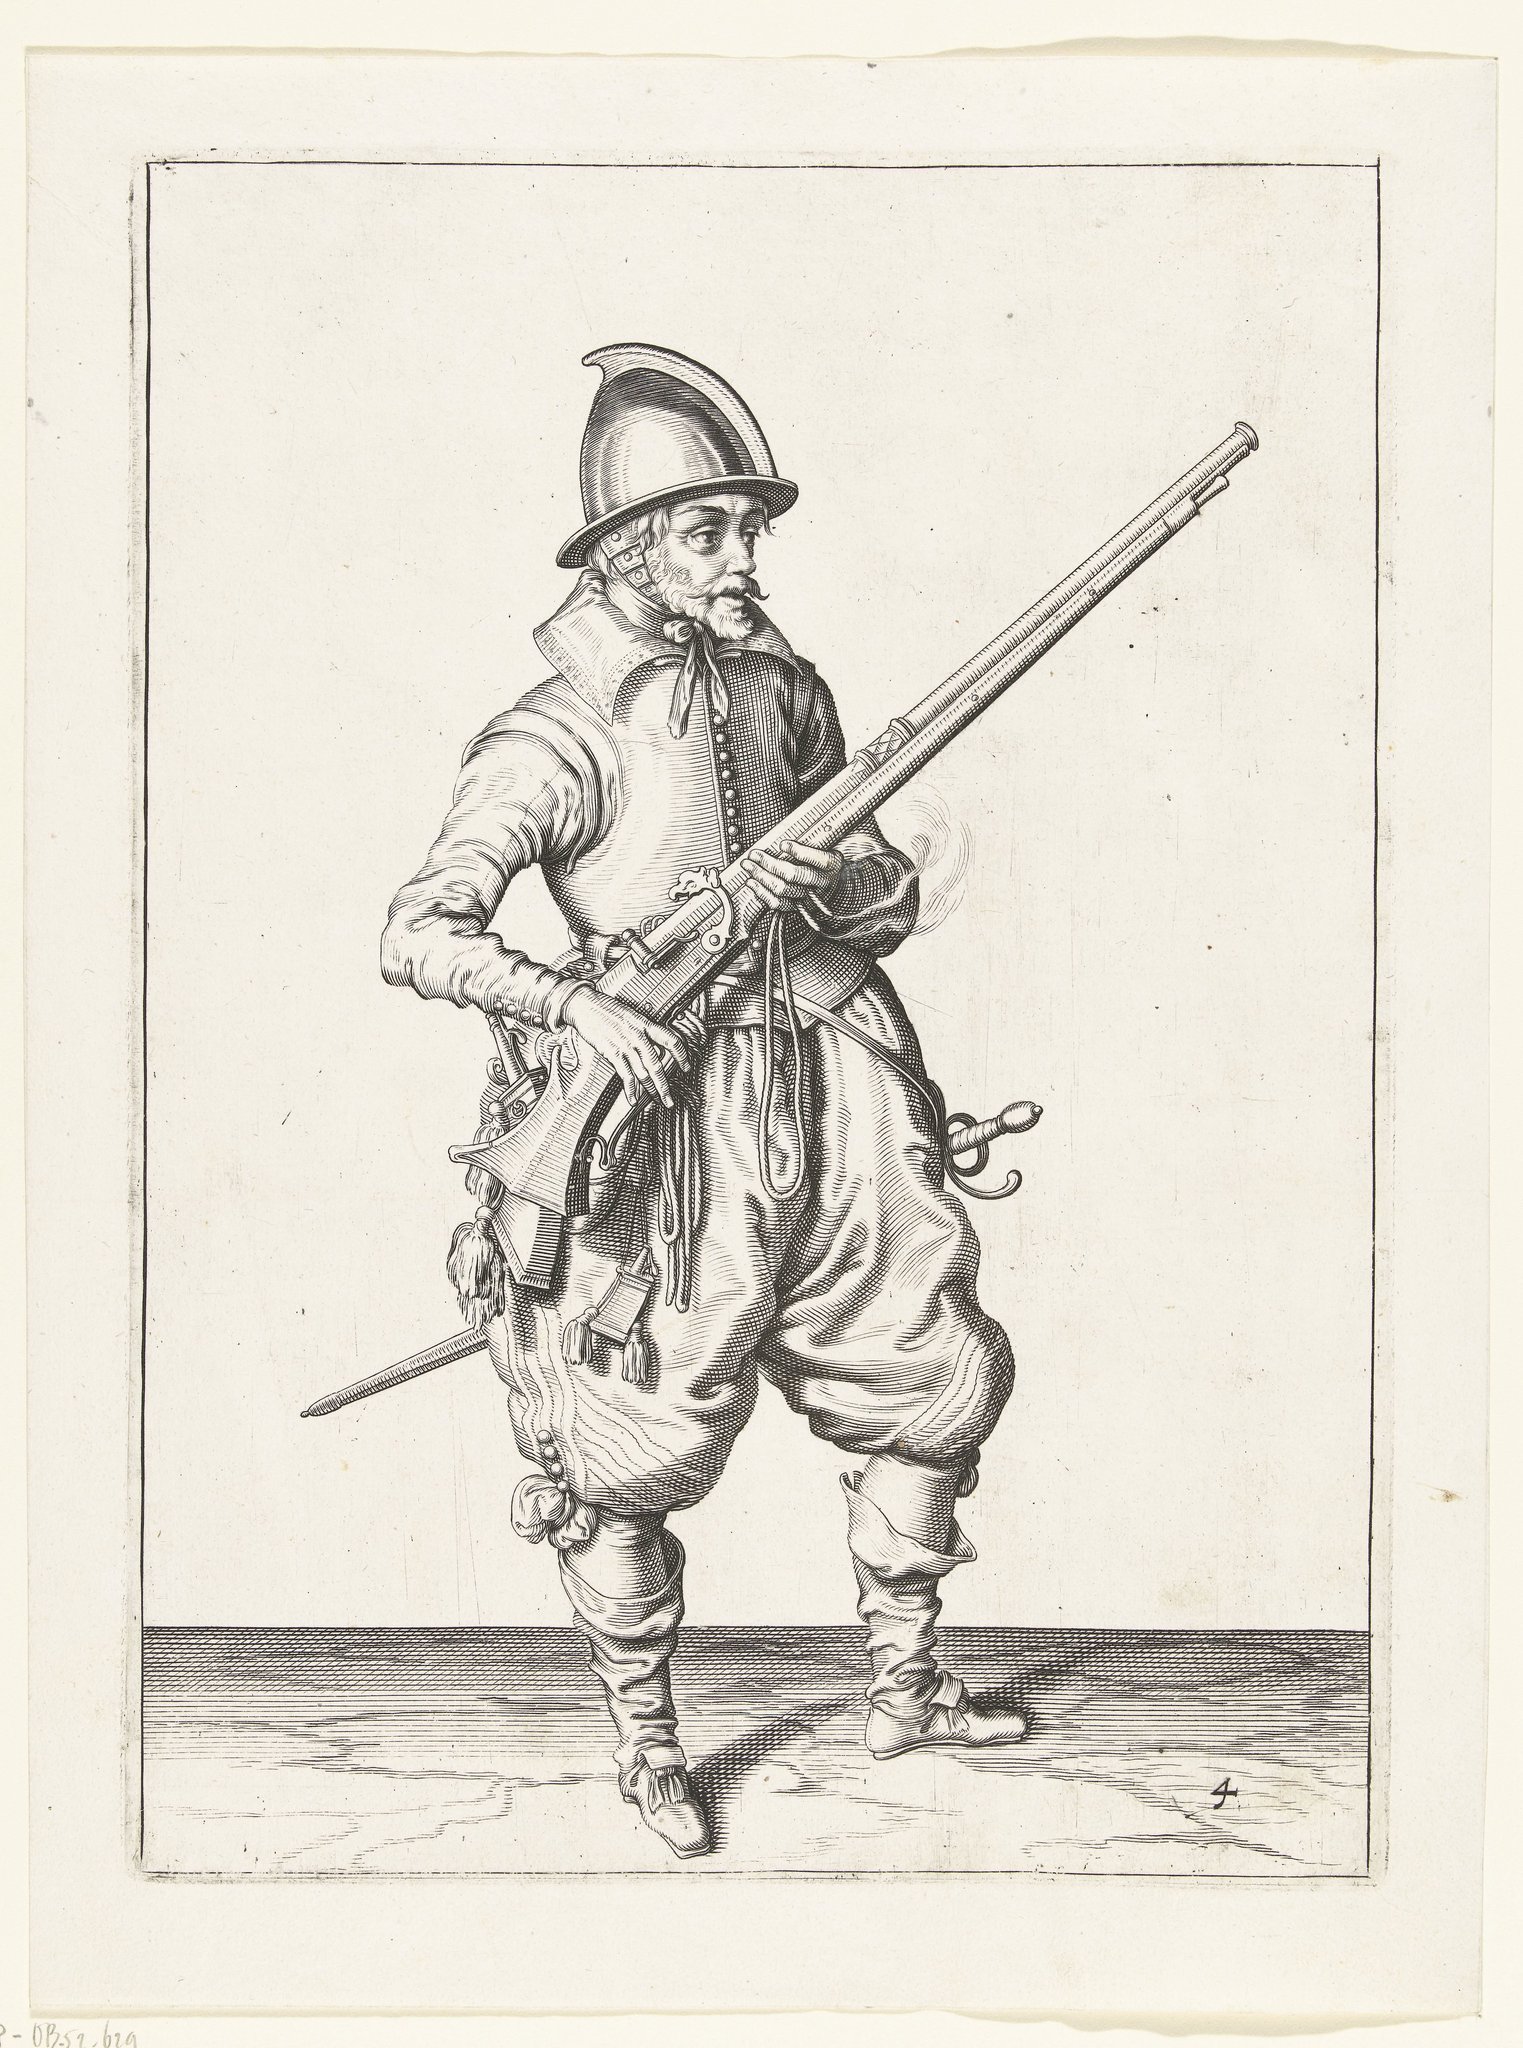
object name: print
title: Soldaat die zijn roer met zijn linkerhand bij zijn rechterzijde vasthoudt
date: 1597-1607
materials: paper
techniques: engraving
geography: netherlands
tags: manoeuvre ~ military training, firearms: rifle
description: Een soldaat, ten voeten uit, naar rechts, die een roer (een bepaald type vuurwapen) met zijn linkerhand bij zijn rechterzijde vasthoudt. In zijn linkerhand behalve het roer ook een brandende lont. Zijn rechterhand losjes bij de trekker van het roer. Deze prent is onderdeel van de reeks van 42 genummerde prenten van roerschutters uit de Wapenhandelinghe.